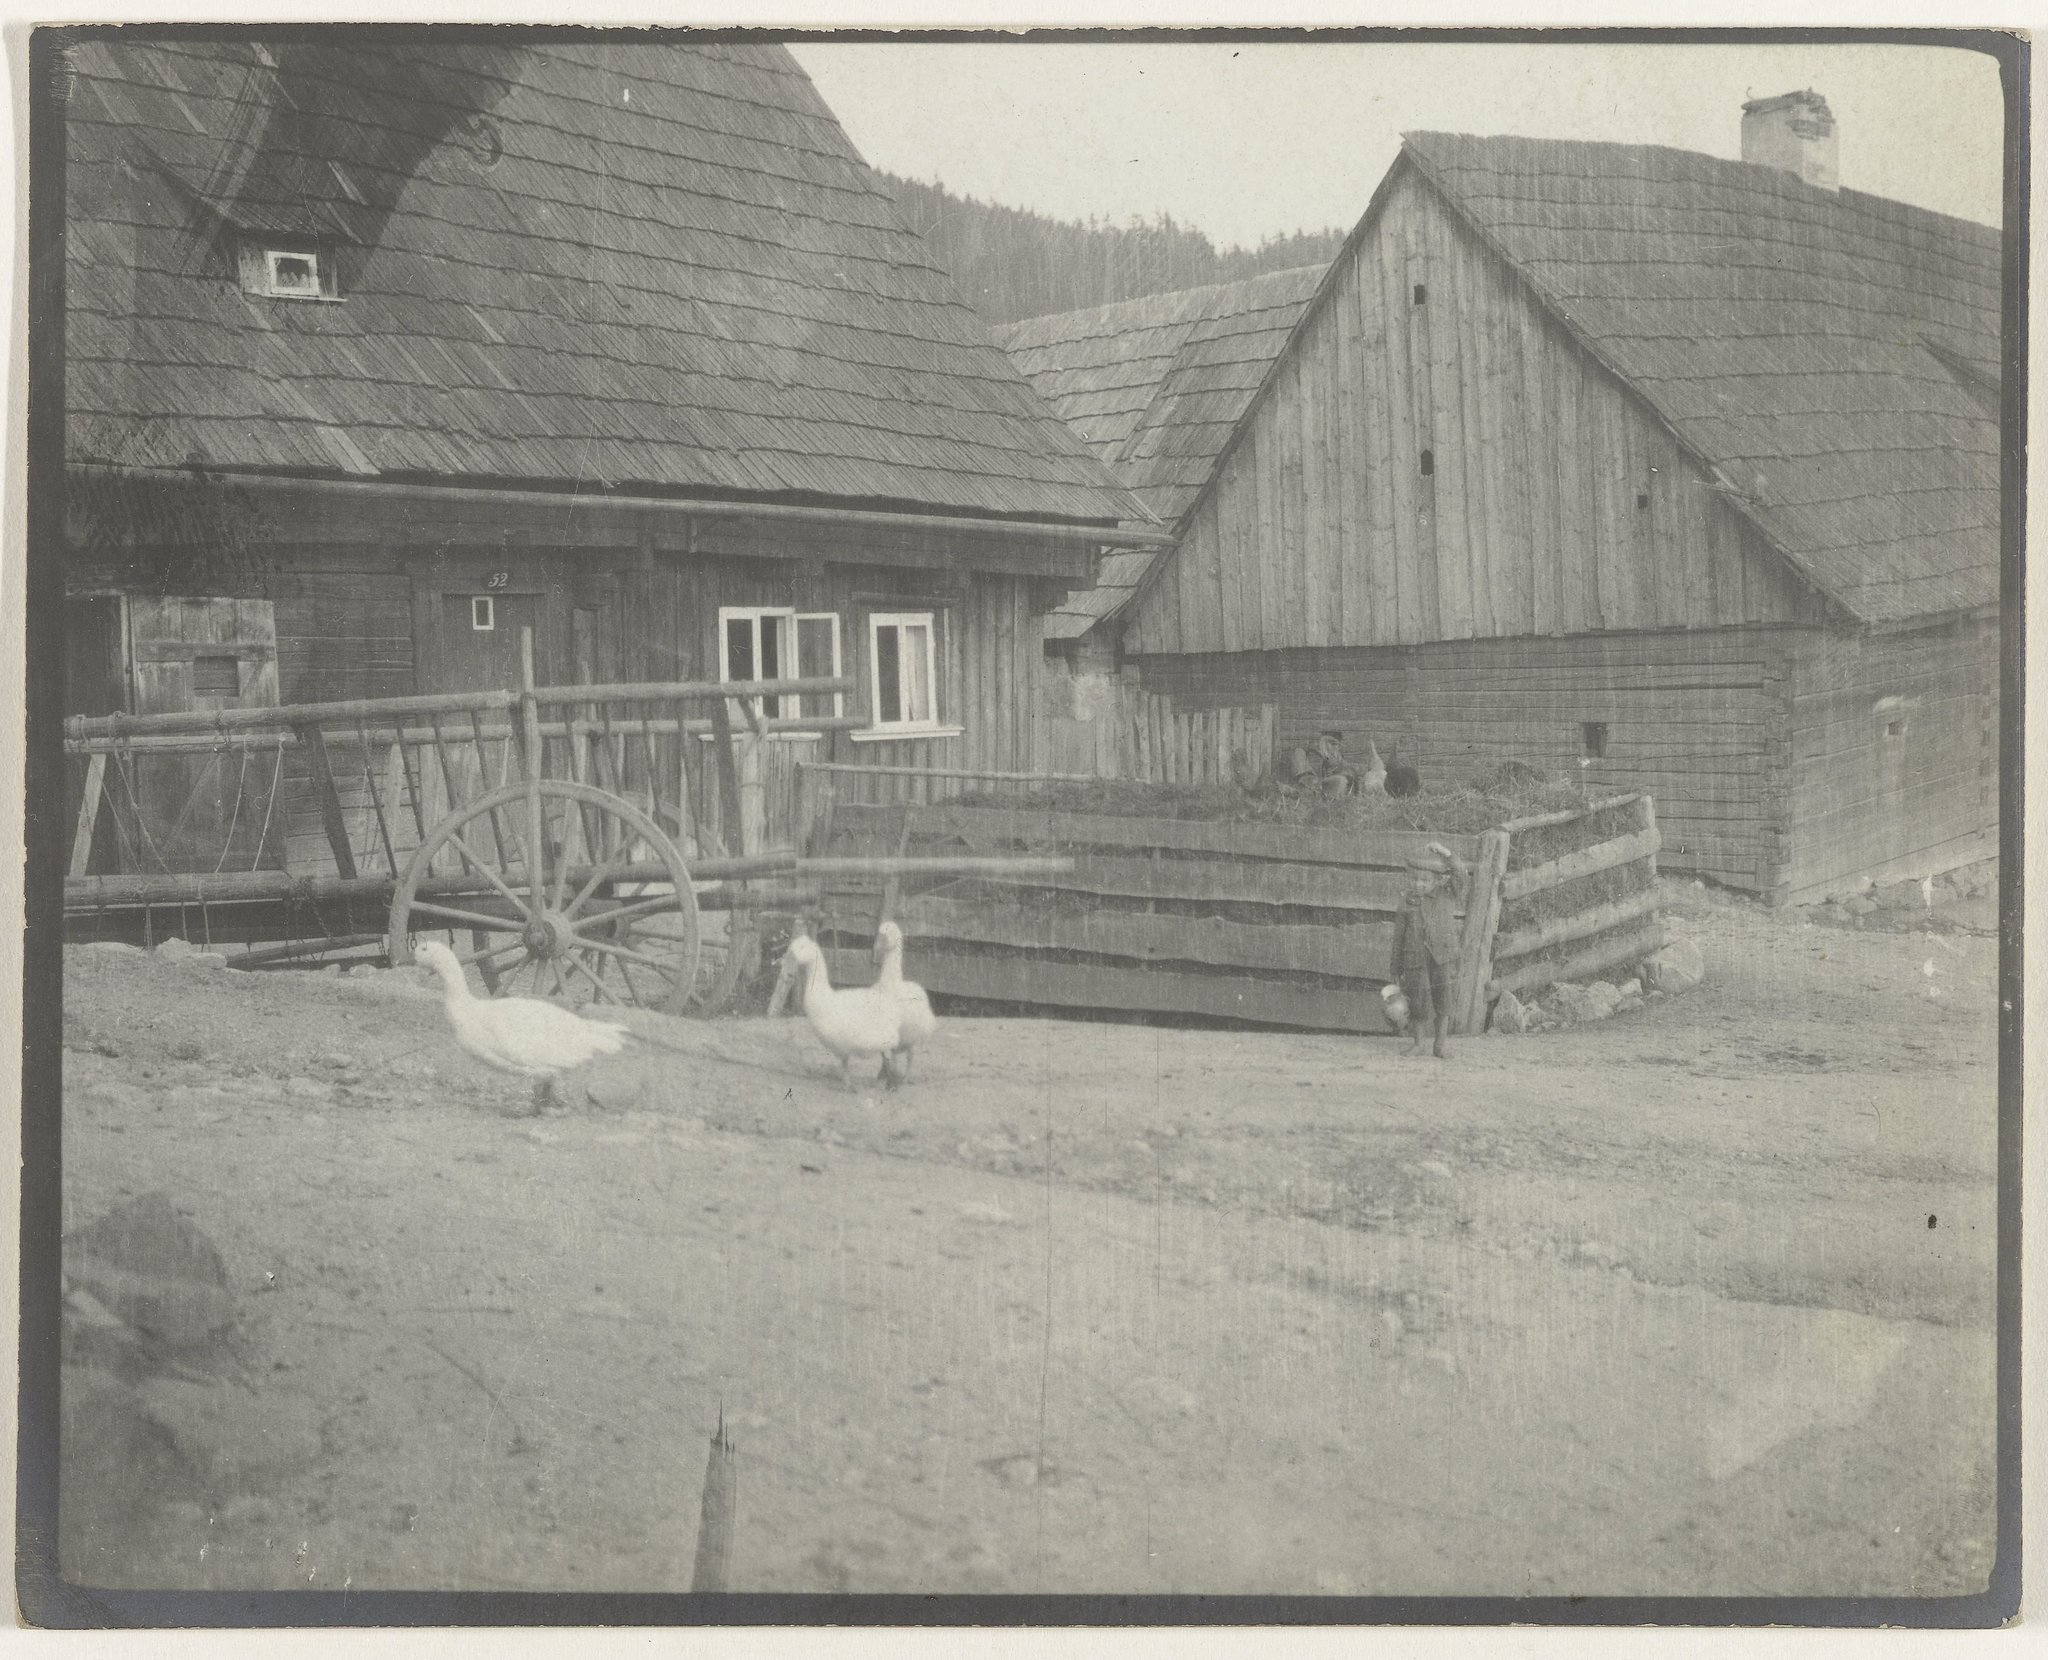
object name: photograph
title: Ganzen op het erf van een boerderij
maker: Anonymous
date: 1900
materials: paper, photographic support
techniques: gelatin silver print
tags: water-birds: goose, farm (building)